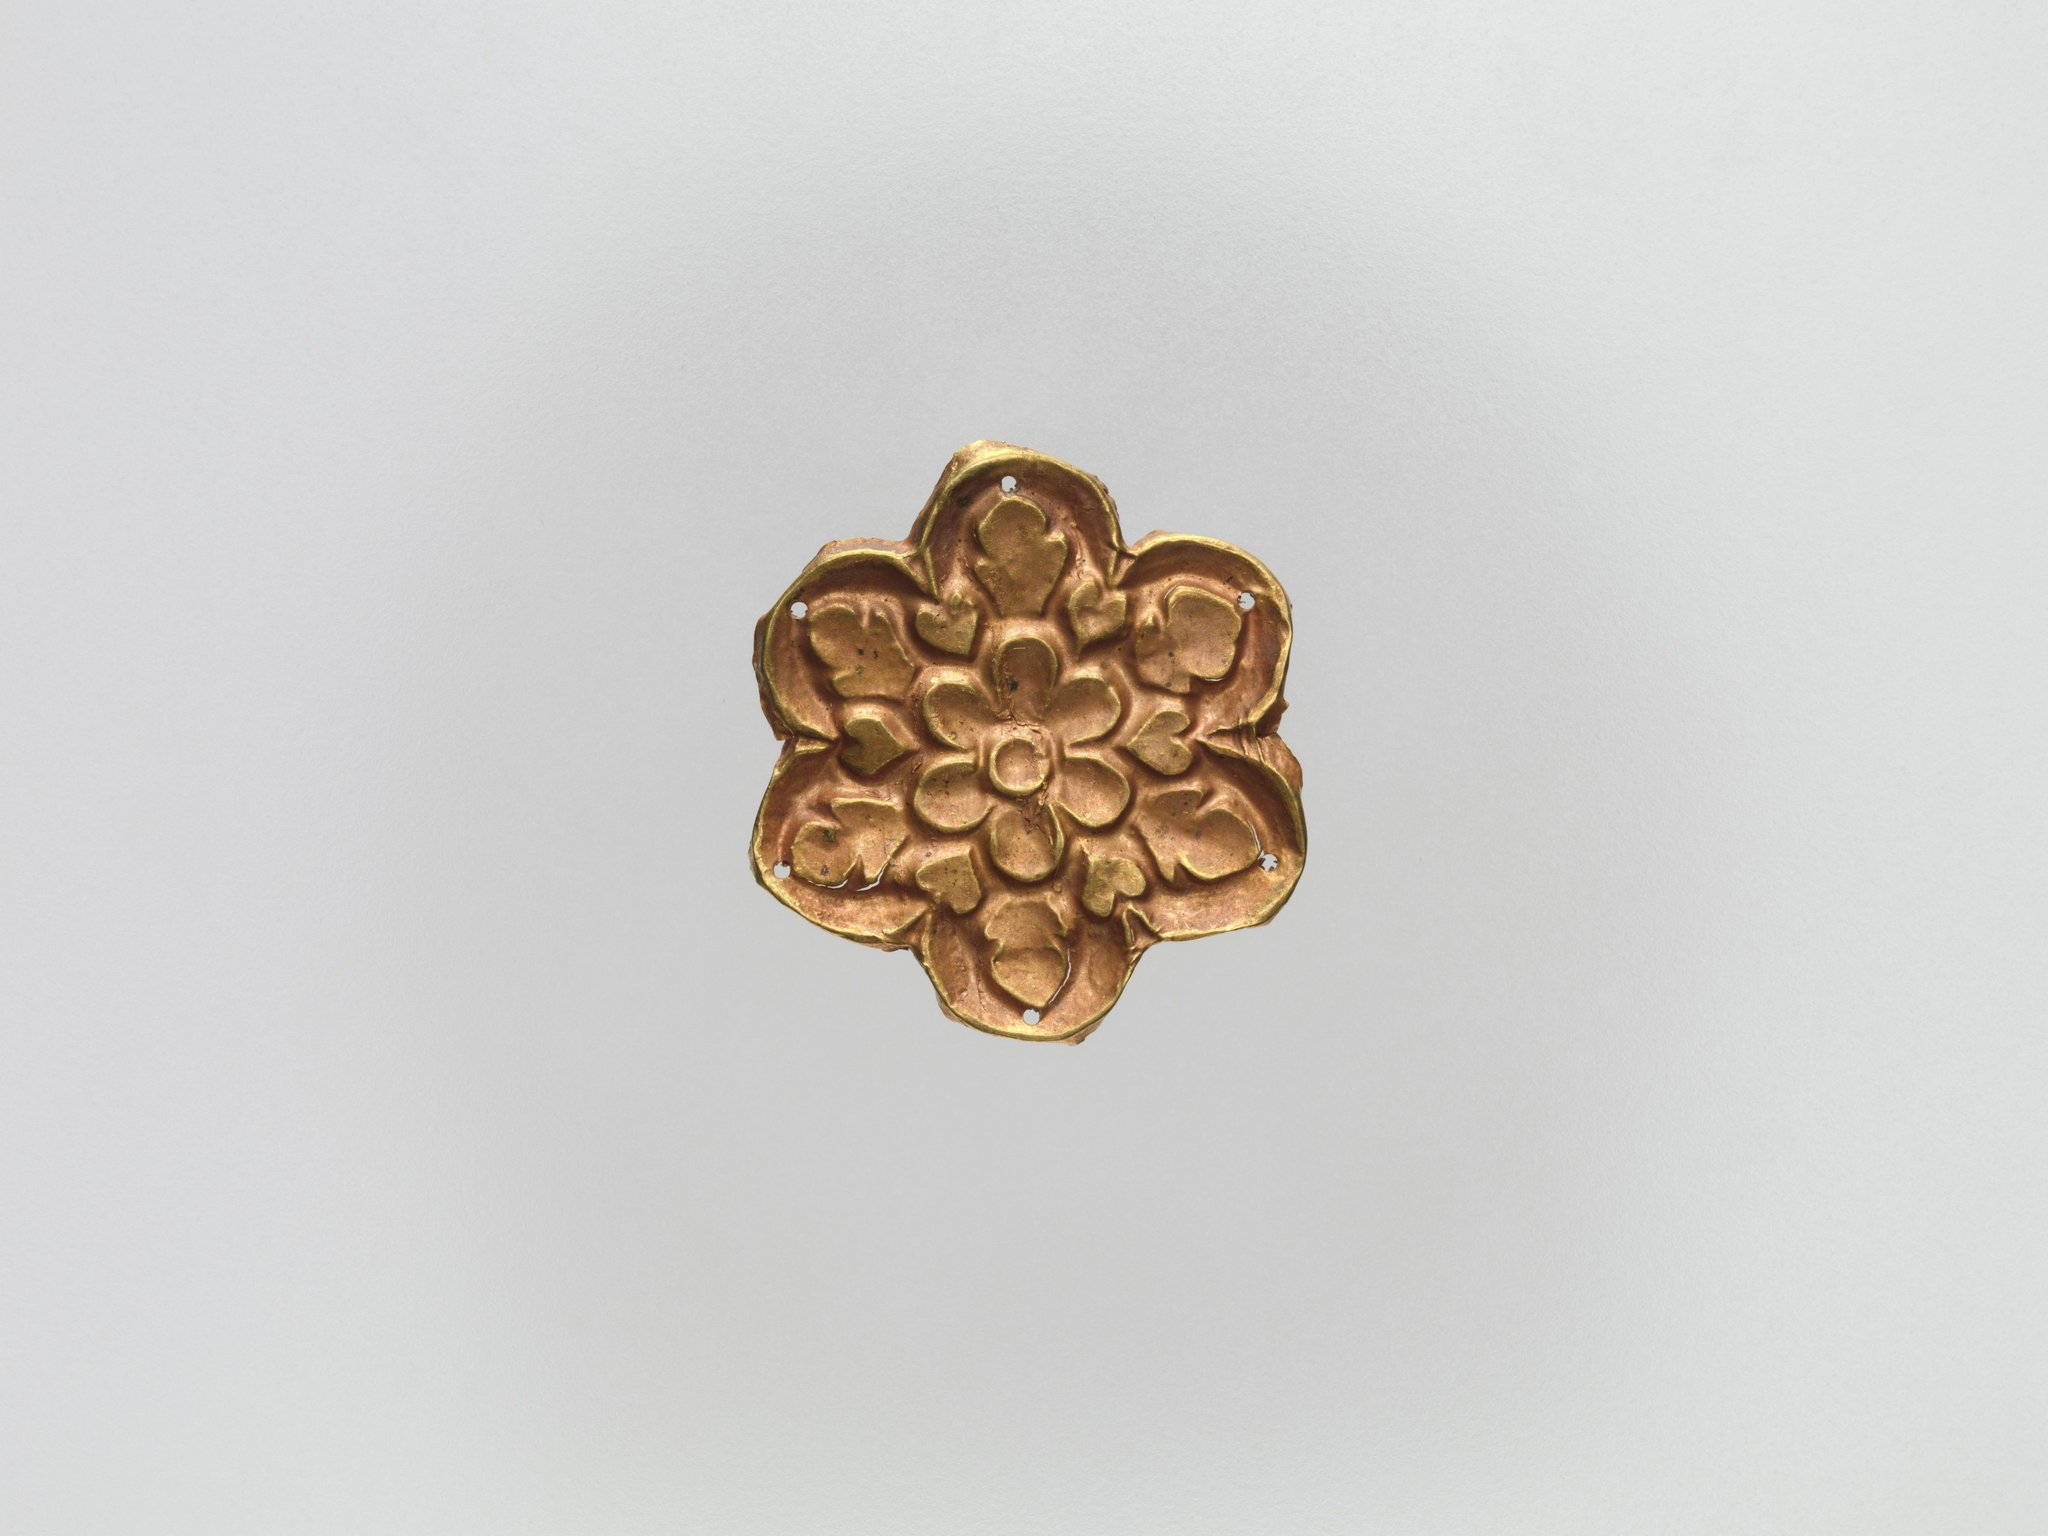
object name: fitting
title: Flower-Shaped Fitting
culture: northwest chinese or eastern central asian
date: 634-900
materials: gold